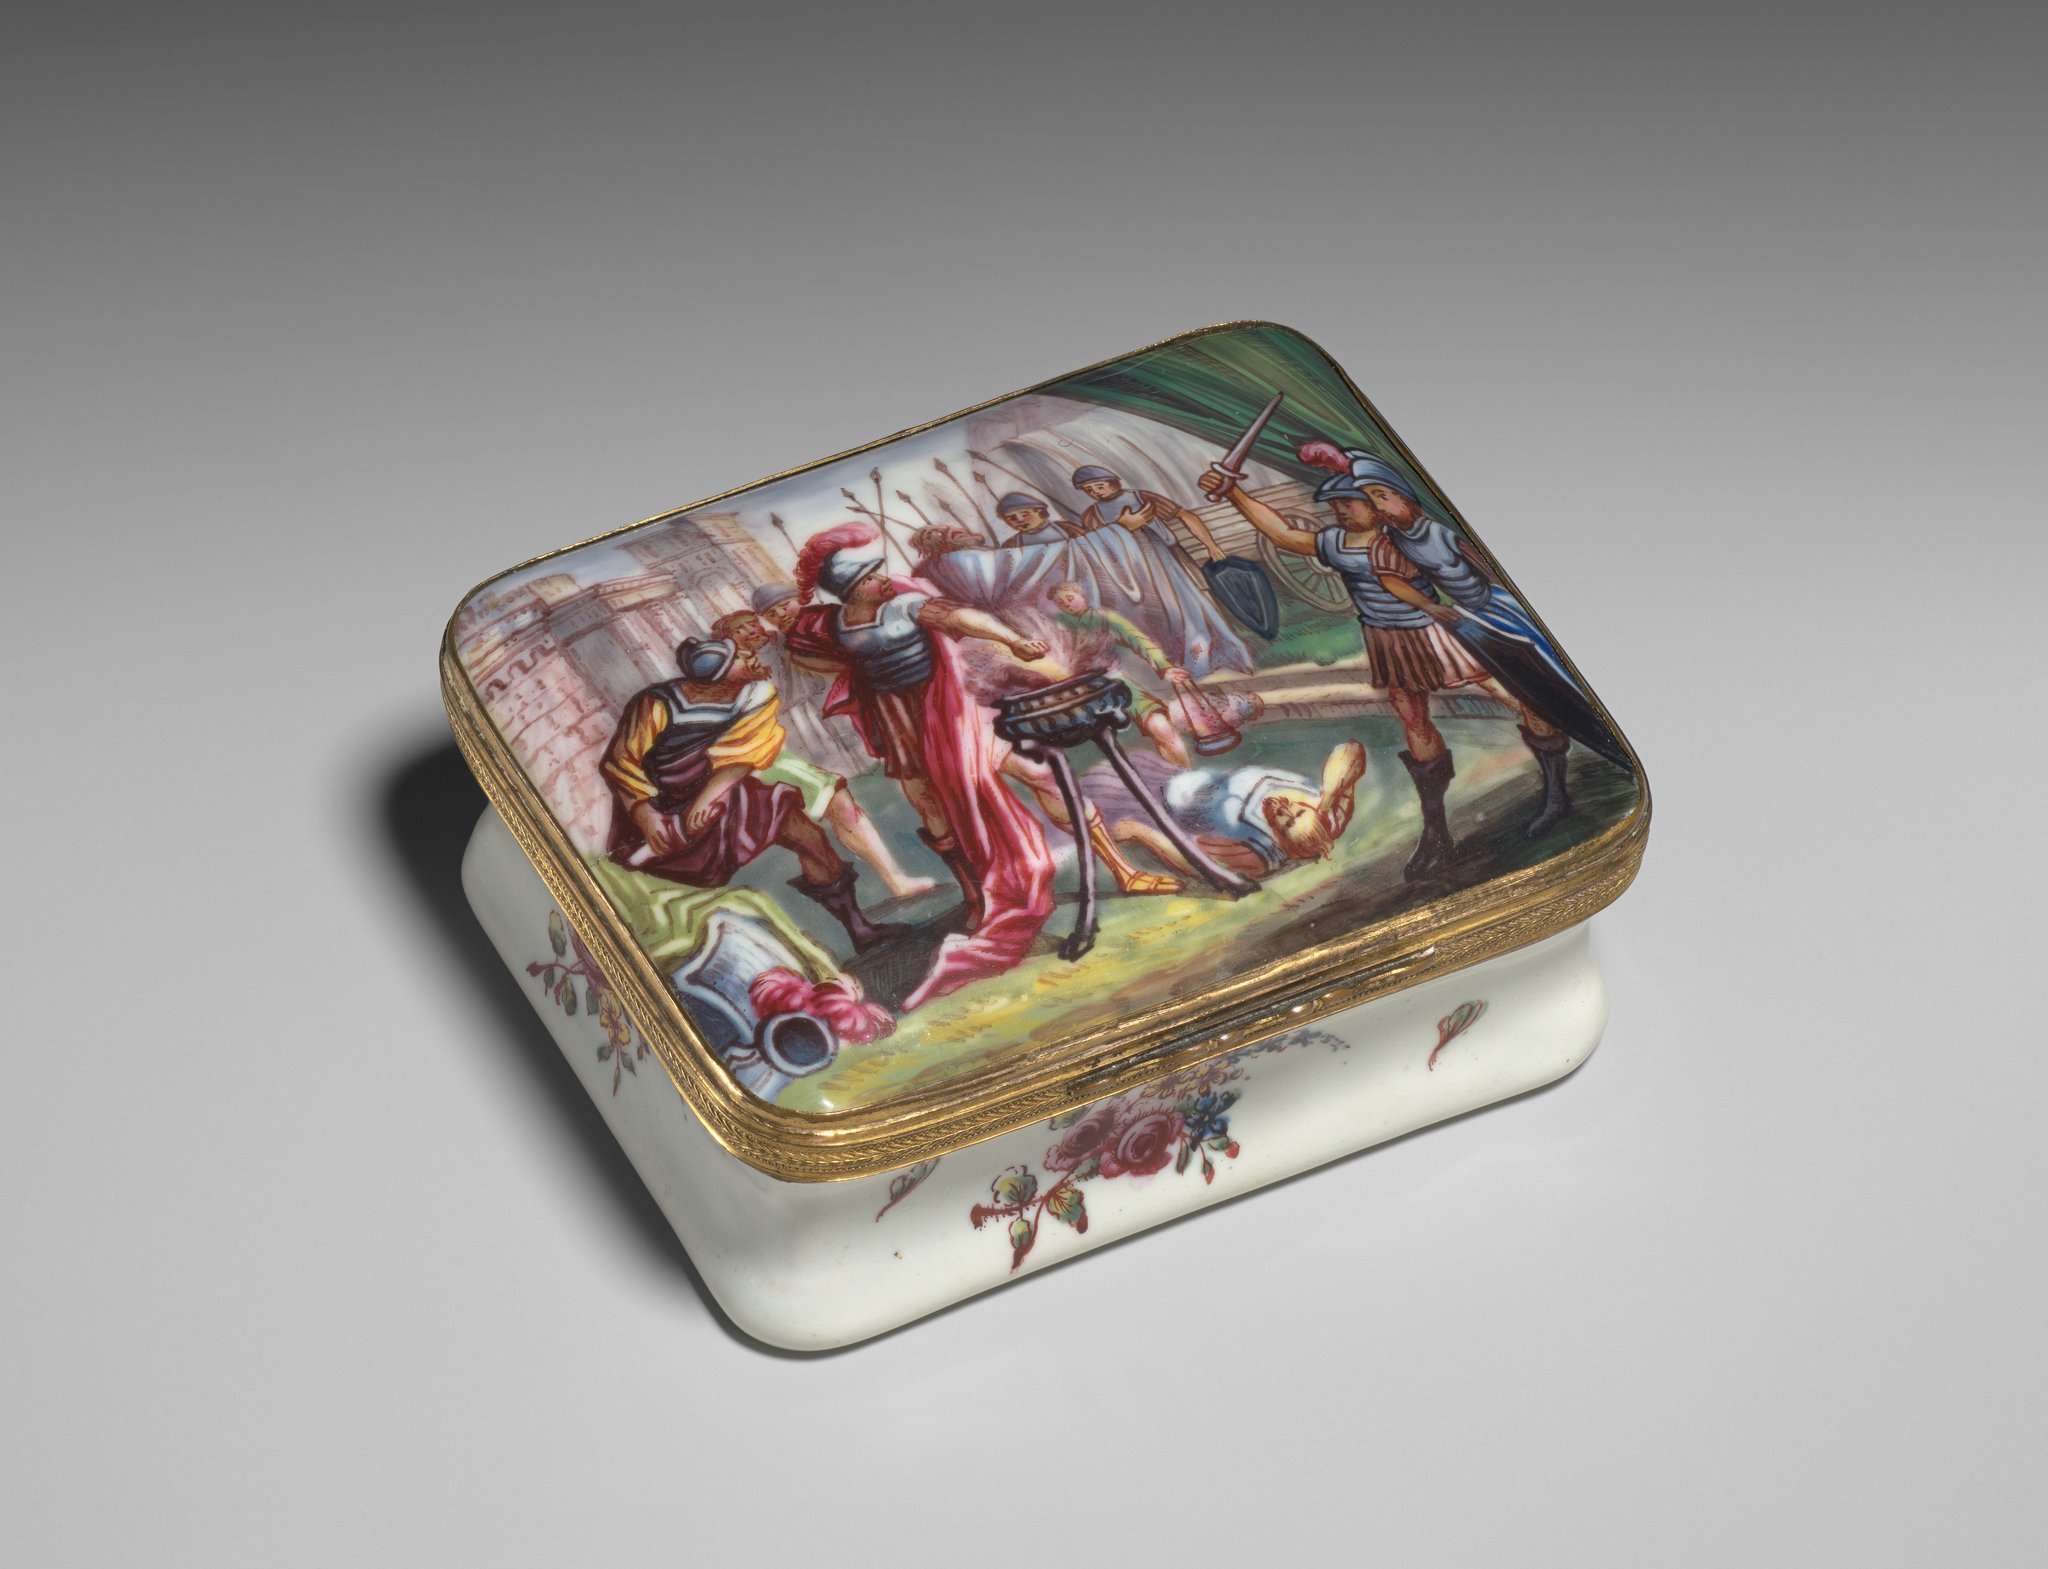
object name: snuffbox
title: Mucius Scaevola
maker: joseph goupy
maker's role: engraver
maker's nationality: french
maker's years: 1689-1769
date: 1755-1760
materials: copper, enamel